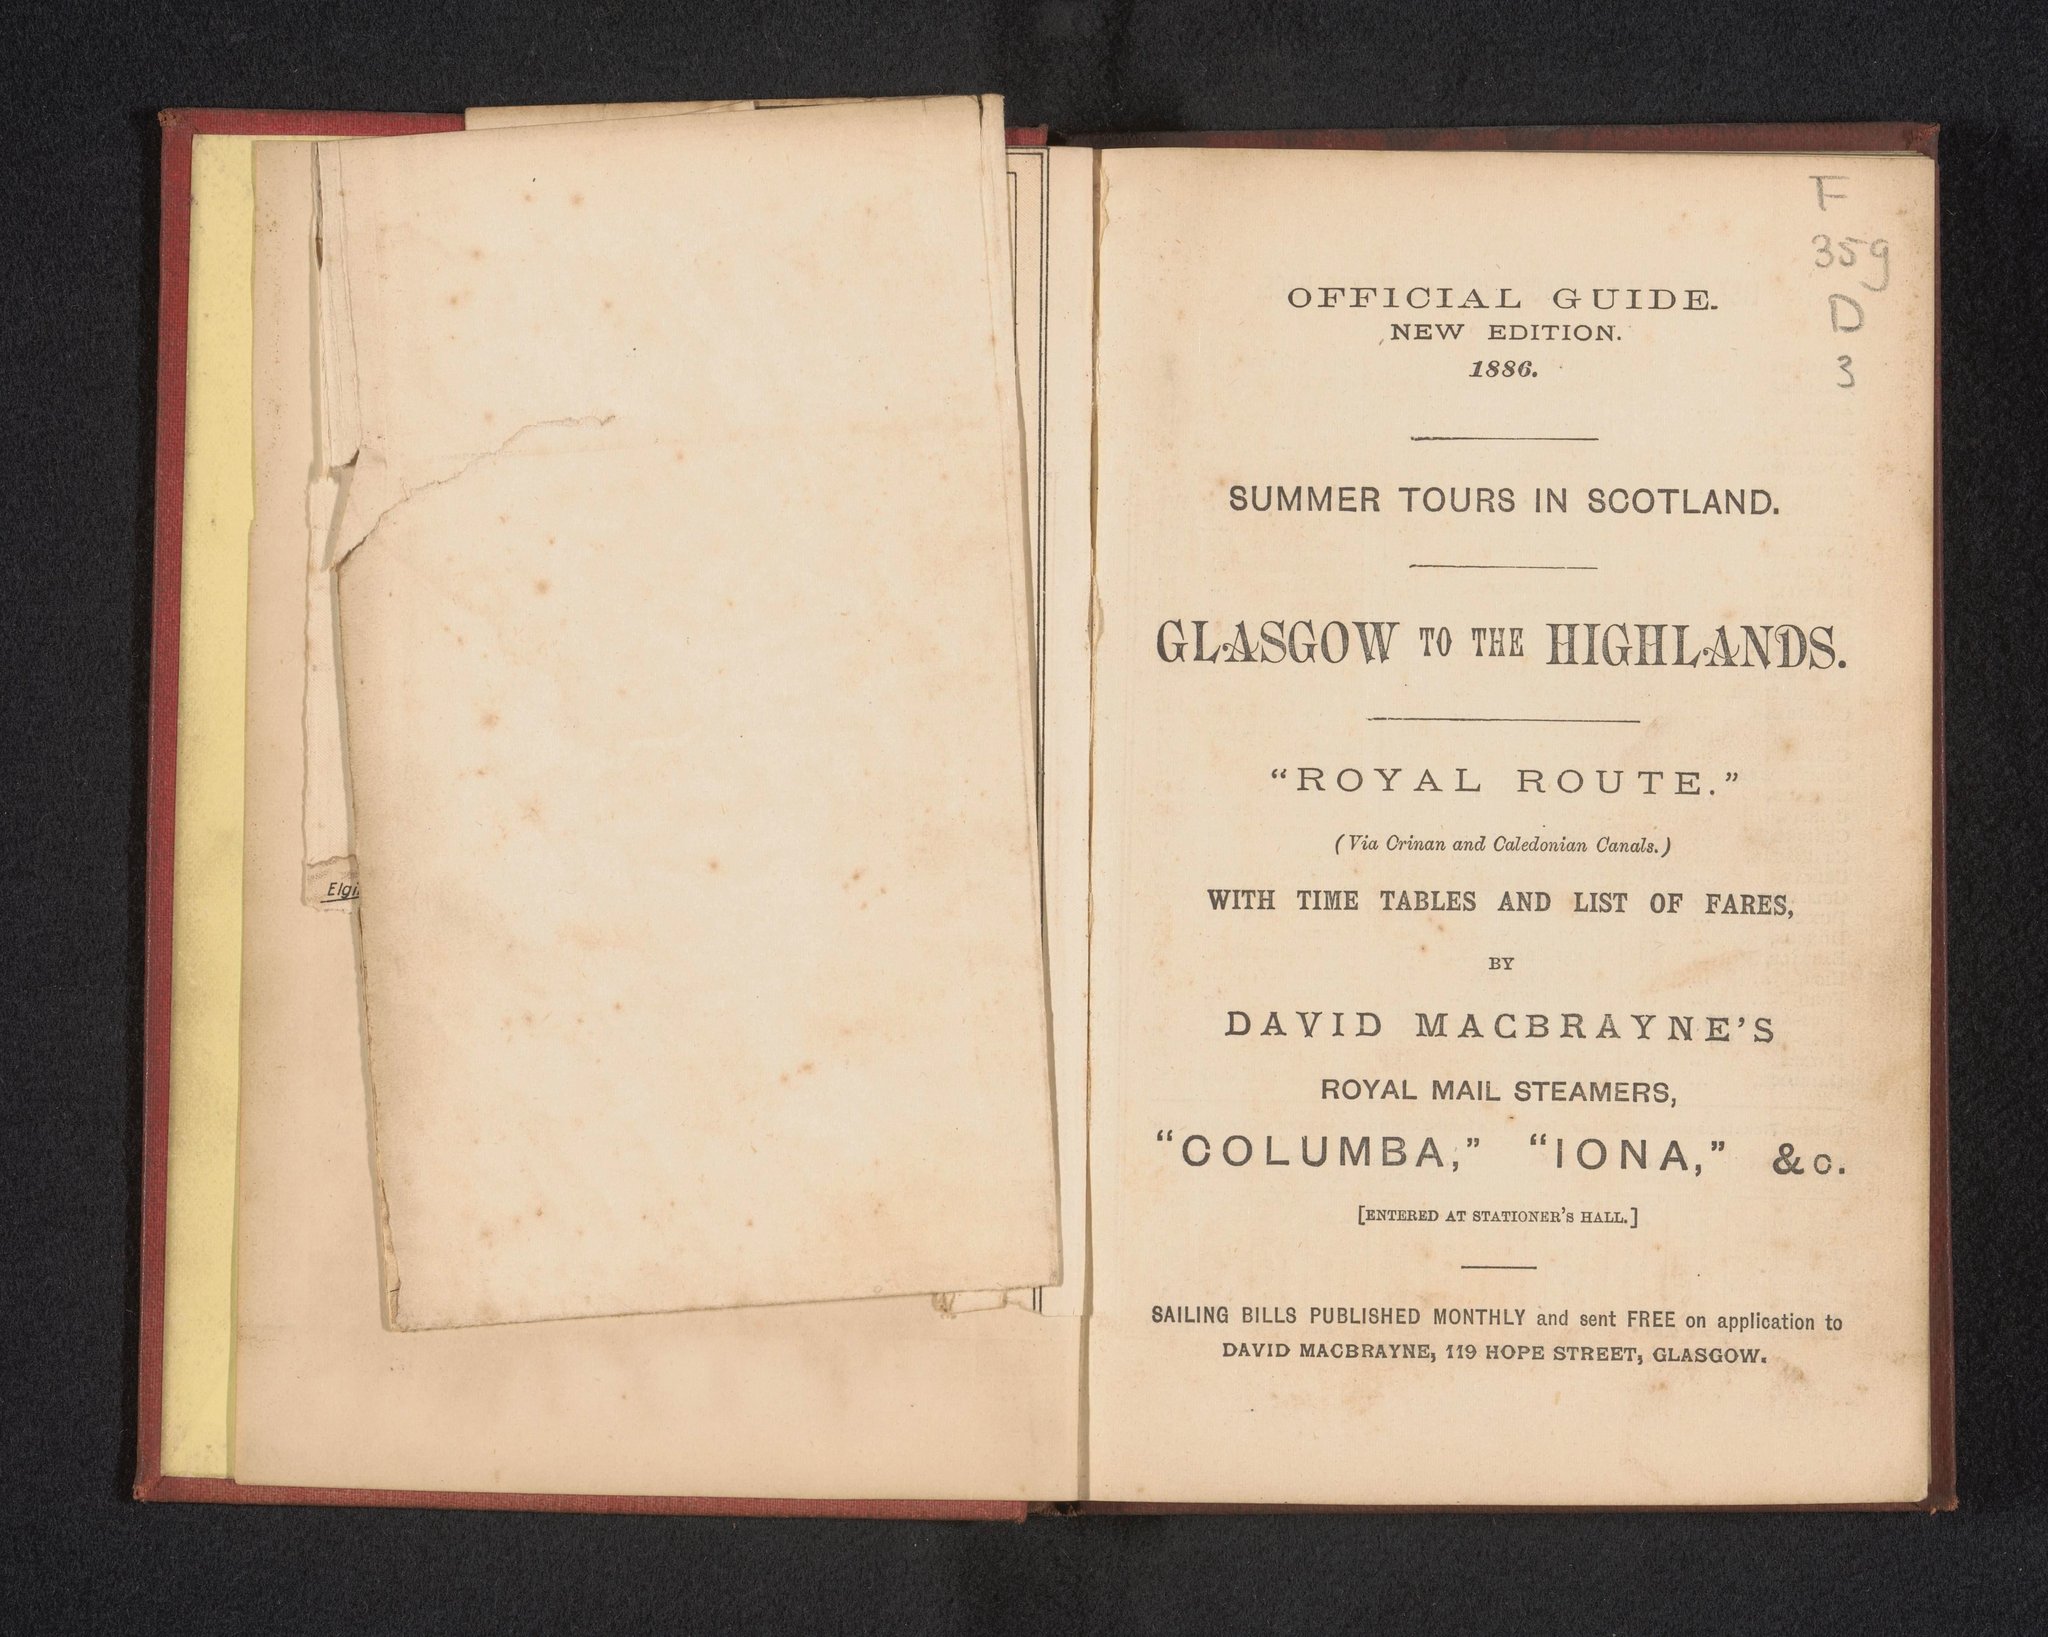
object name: book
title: Summer tours in Scotland : Glasgow to the Highlands : "Royal Route," ... with time tables and list of fares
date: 1886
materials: linen, paper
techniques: photograph, printing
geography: glasgow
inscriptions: date: ‘Feb 1995’, annotation: ‘£12’